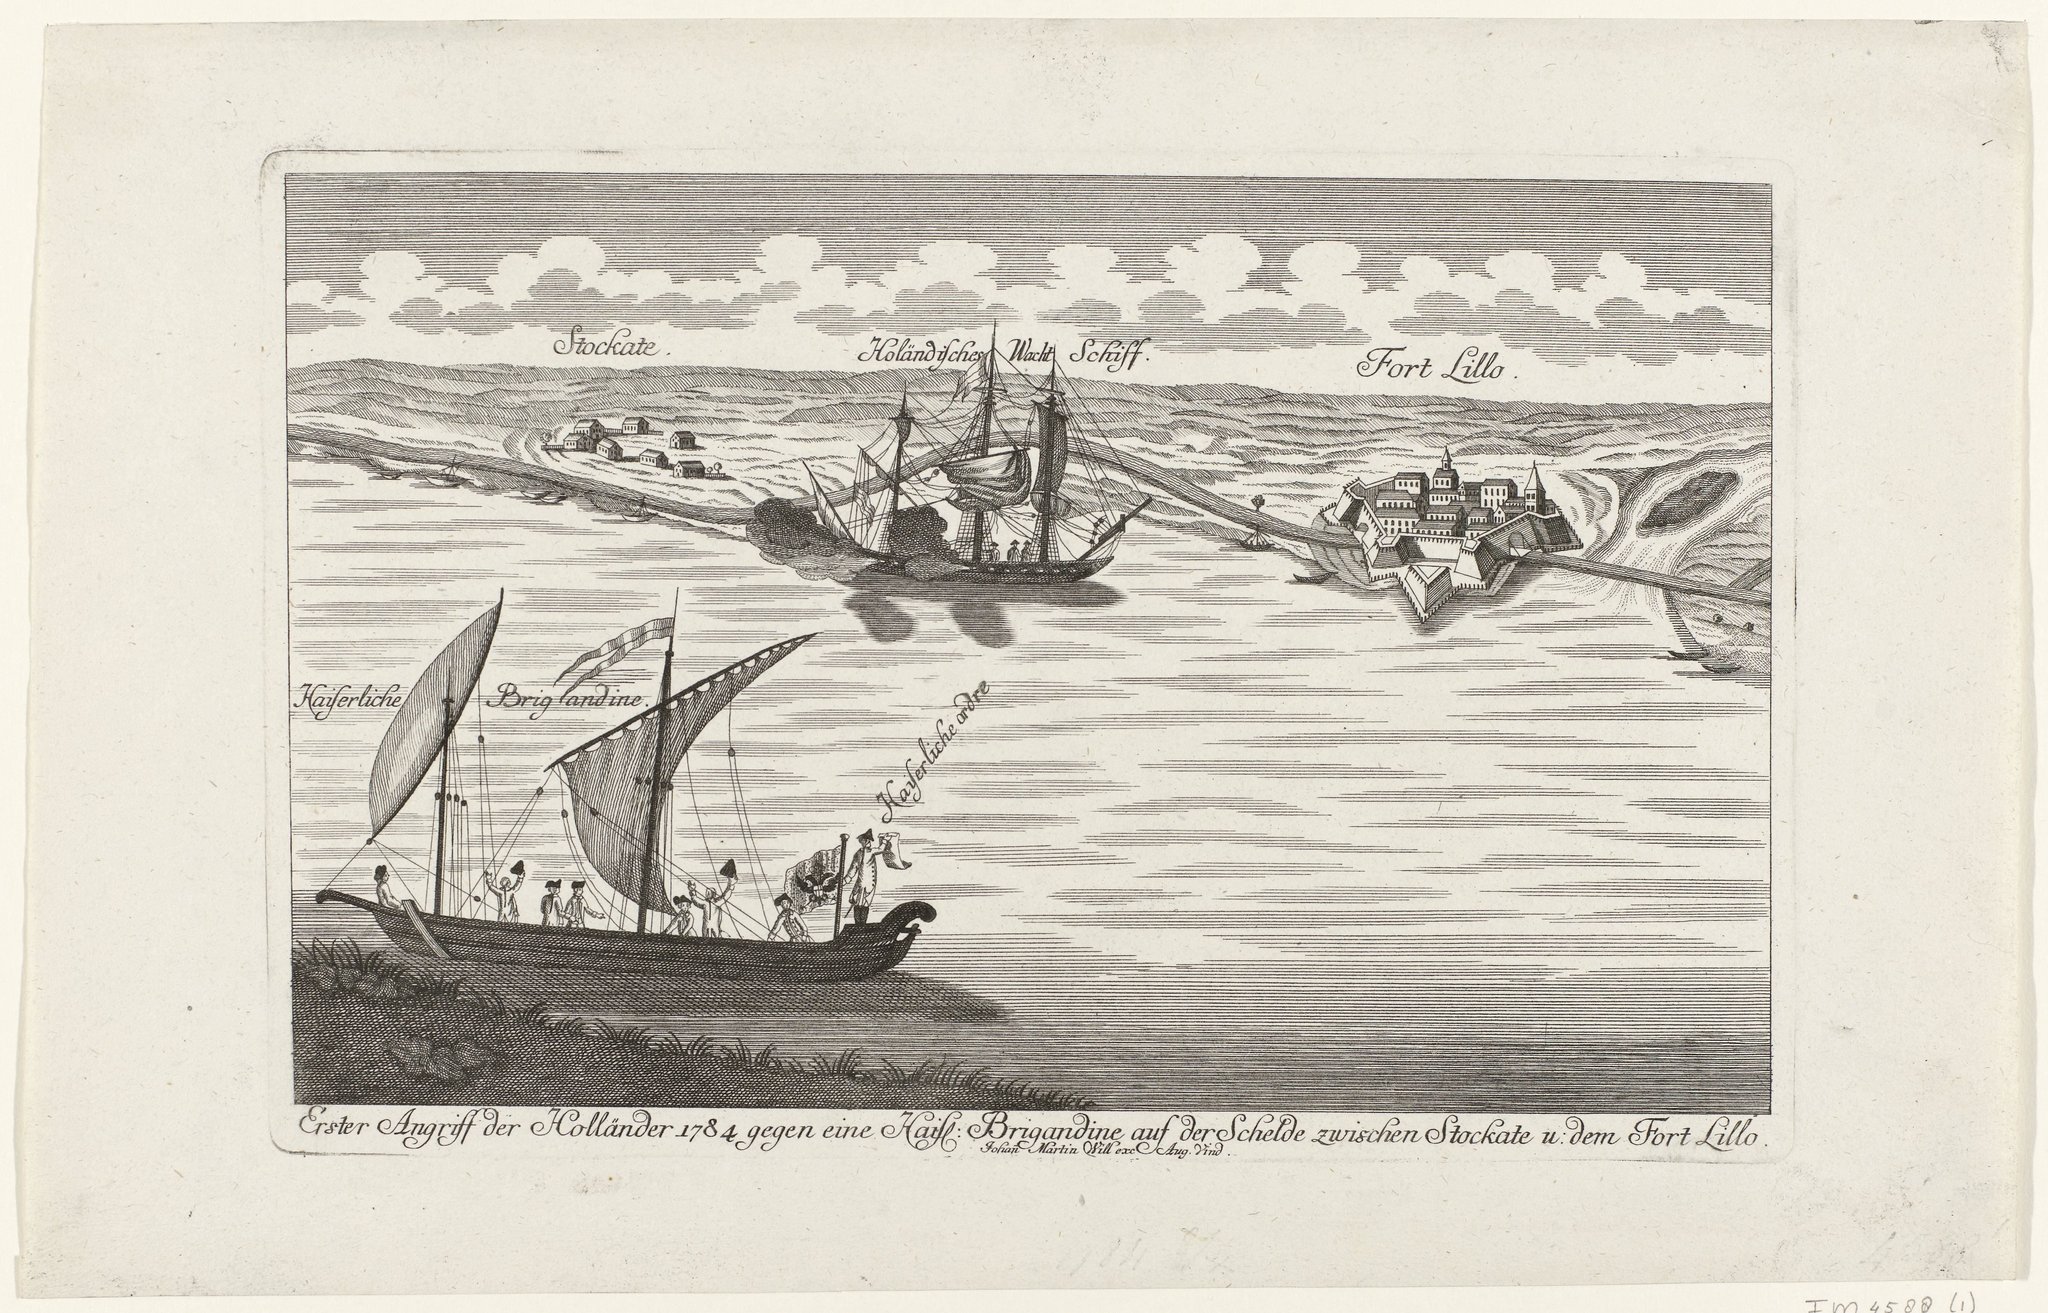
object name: print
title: Ophouden van de keizerlijke brik op de Schelde bij Fort Lillo, 1784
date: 1784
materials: paper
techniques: etching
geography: augsburg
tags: battle (+ sailing-ships)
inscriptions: collector's mark: Lugt 2228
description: Het ophouden van de Oostenrijkse keizerlijke brik de Louis door de Nederlandse schoener de Dolphijn onder commando van luitenant Tobias Tak Cuperus op de Schelde bij Fort Lillo, 8 oktober 1784. Het Nederlandse schip vuurt een waarschuwingsschot. De incidenten op deze dag worden aangeduid met de spotnaam de Keteloorlog. Bij deze prent behoort een pendant.